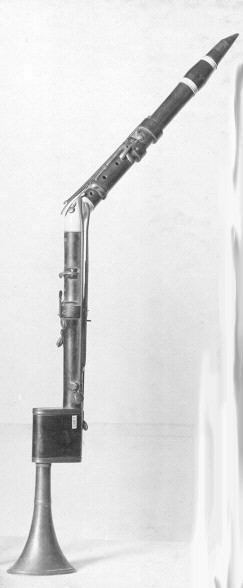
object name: basset horn in f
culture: german or italian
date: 1801-1833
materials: brass, ivory, wood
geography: italy